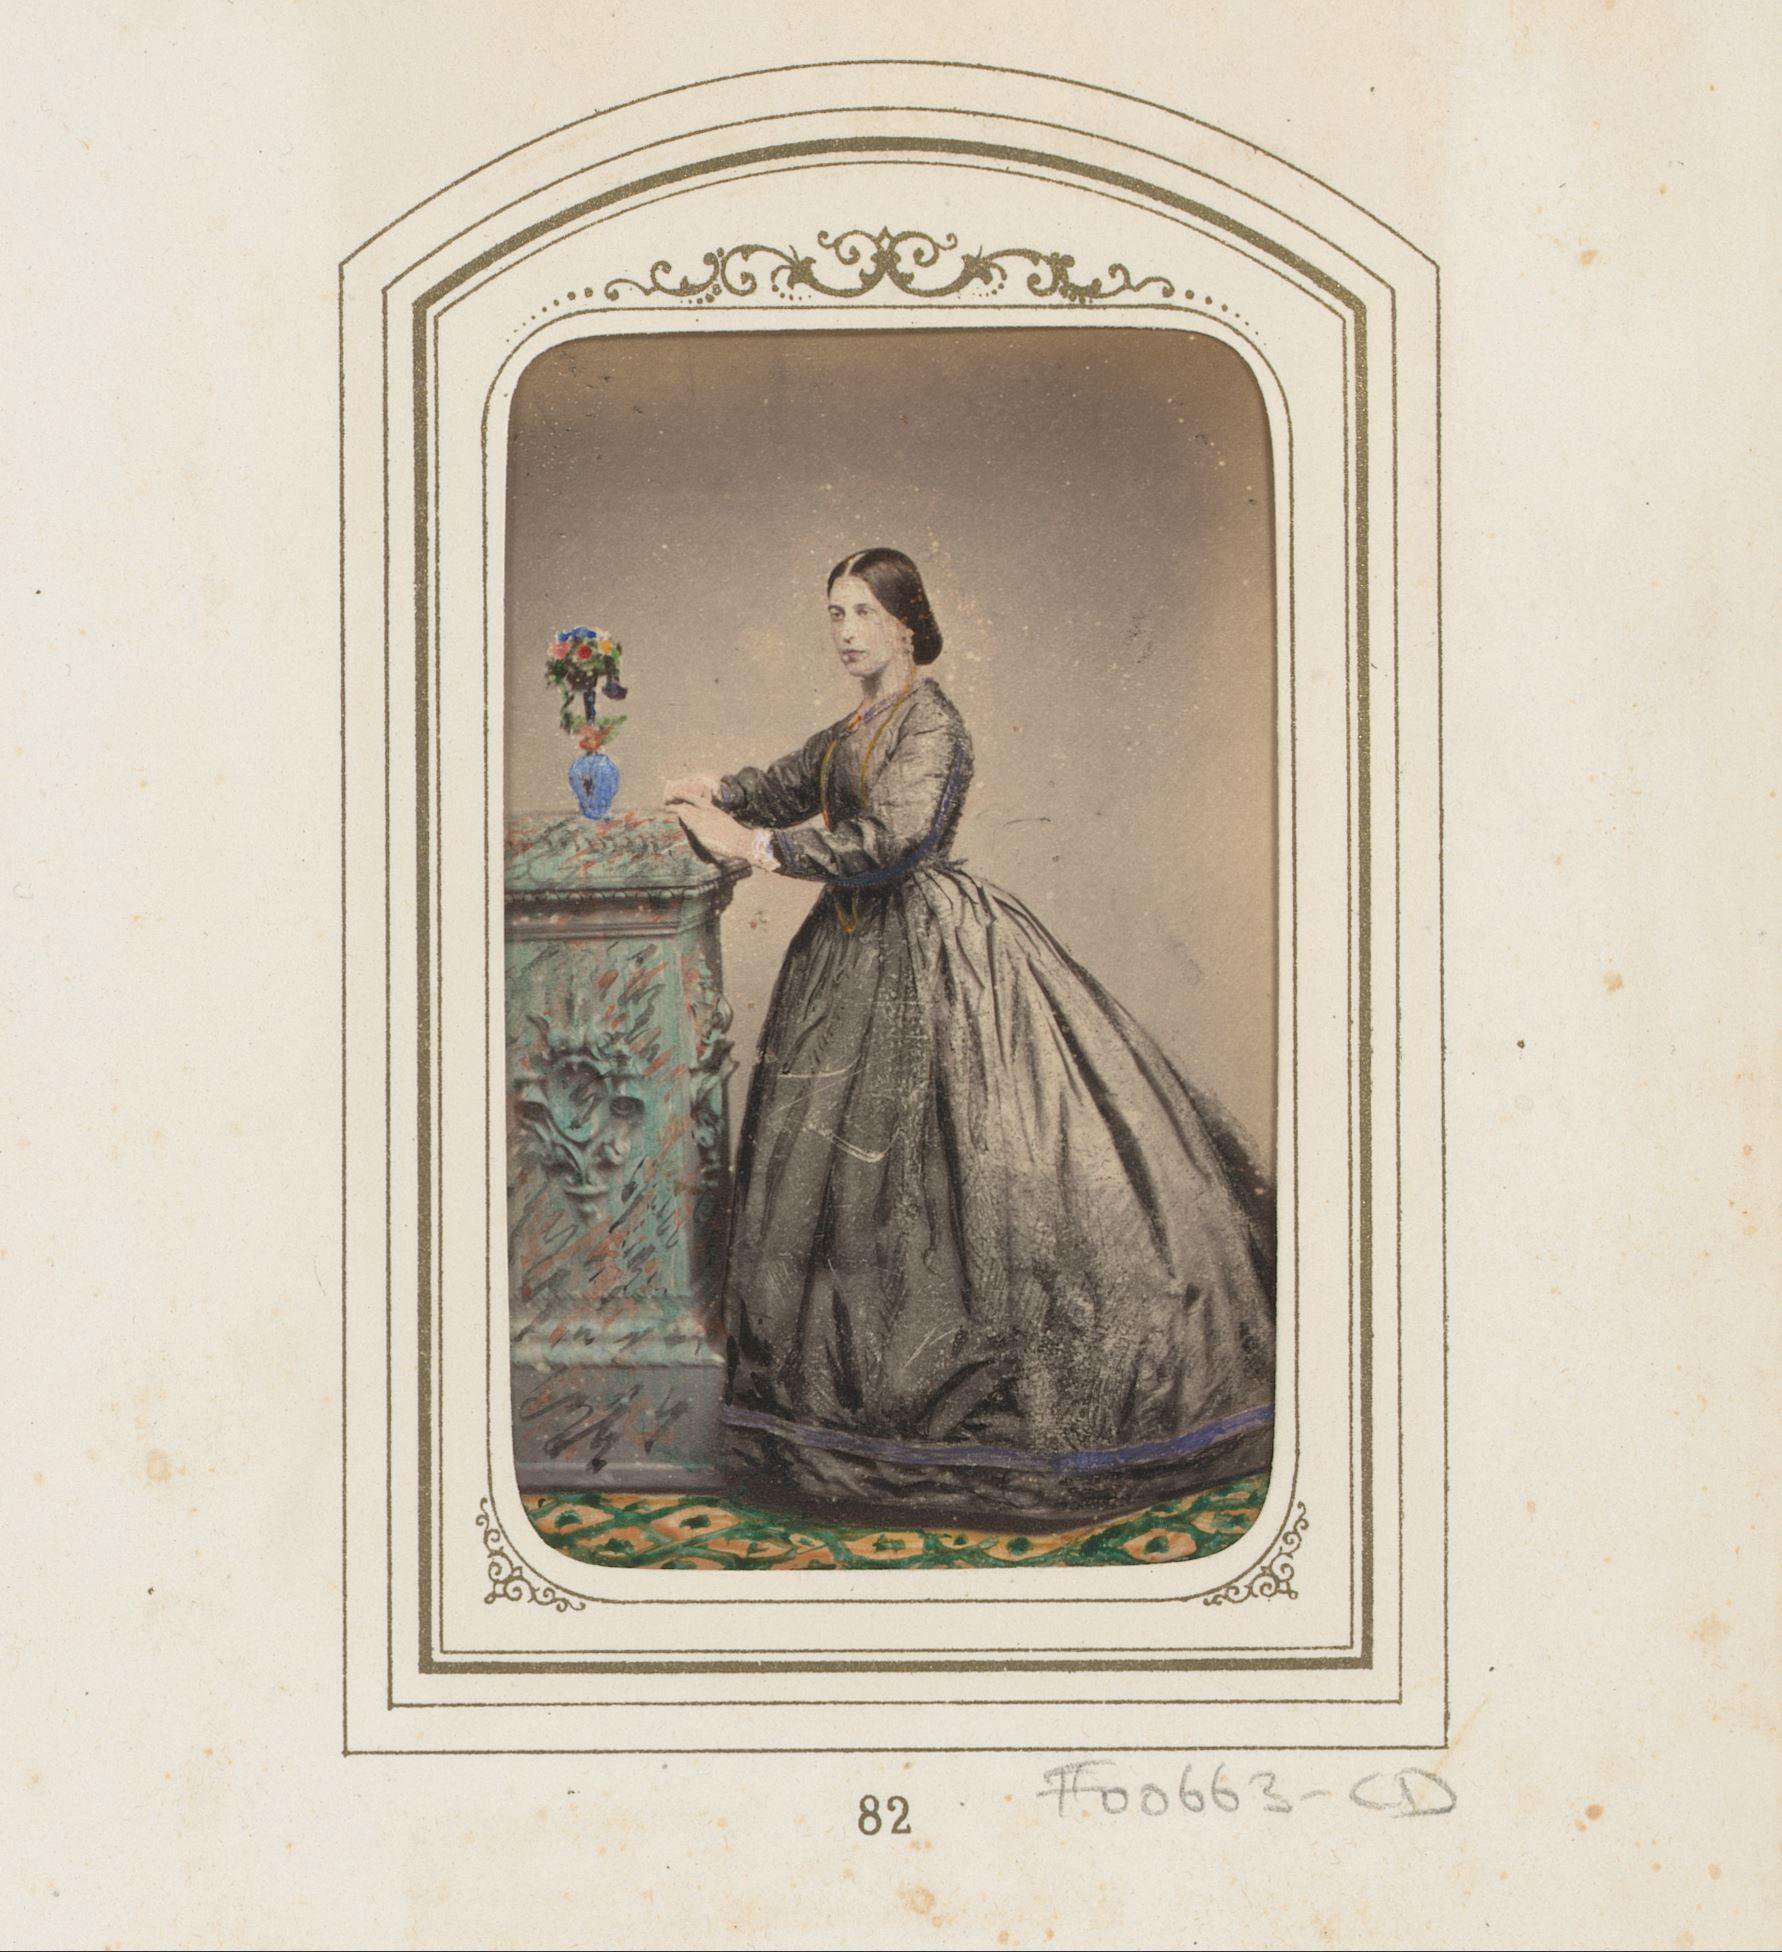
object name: photograph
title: Portret van een staande vrouw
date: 1856-1865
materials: cardboard, photographic support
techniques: albumen print, hand coloring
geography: london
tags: historical persons - bb - woman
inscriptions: inscription: ‘Maull & Polyblank/ Photographers/ 55, Gracechurch street/ 187a, Piccadilly and Tavistock House Fulham Road/ London’, number: ‘82’